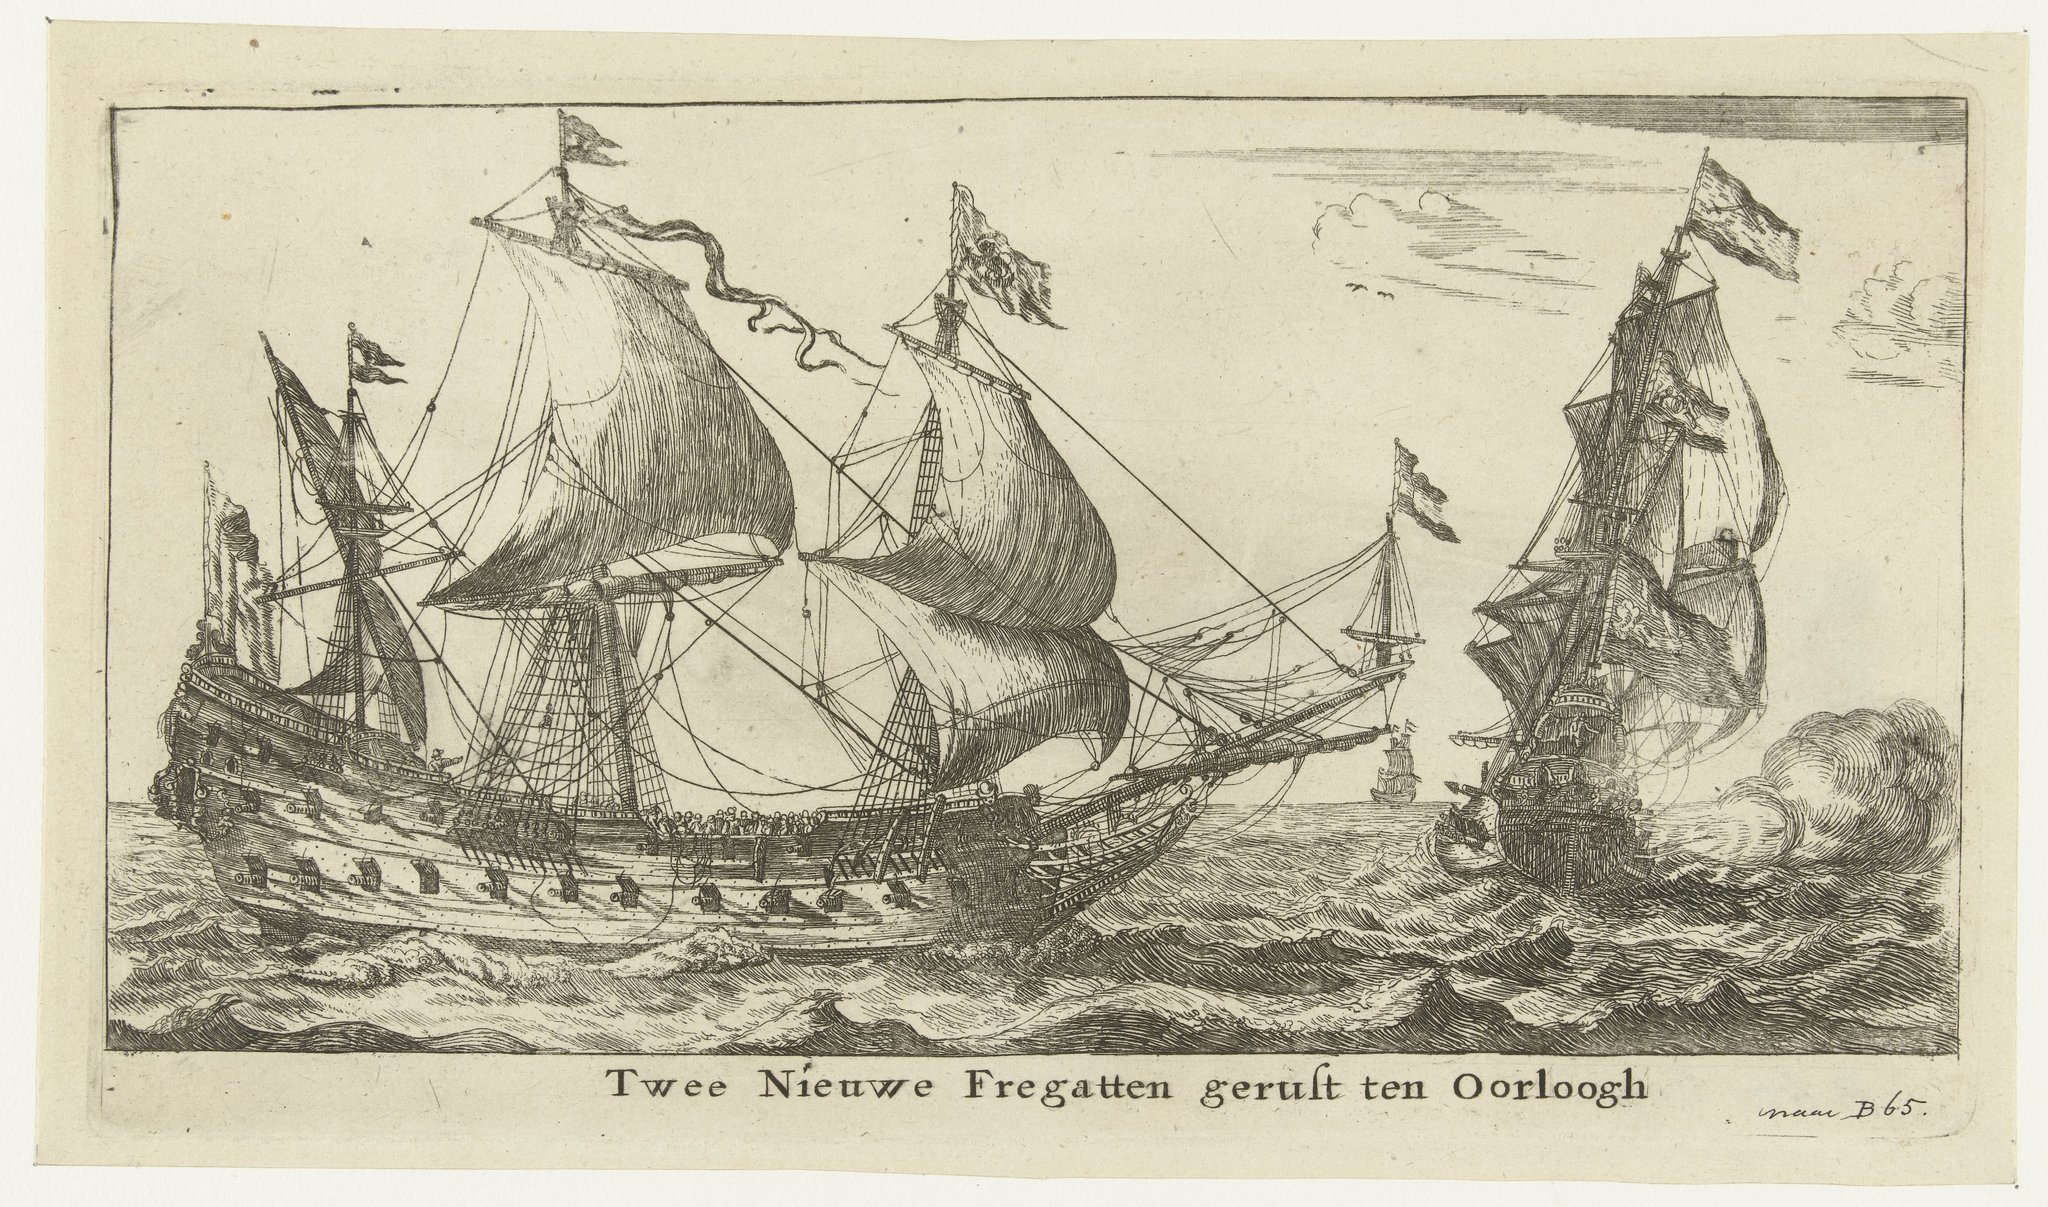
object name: print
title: Twee Nieuwe Fregatten, gerust ten Oorloogh, tegen t' Parlement van Engelandt,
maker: reinier nooms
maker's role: draughtsman, painter, print maker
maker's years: 1623-1664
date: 1652-1654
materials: paper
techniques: drypoint, etching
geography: netherlands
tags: ships (in general)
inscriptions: collector's mark: Lugt 12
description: Twee fregatten met bolle zijlen, één van de achterkant gezien en één van de zijkant.